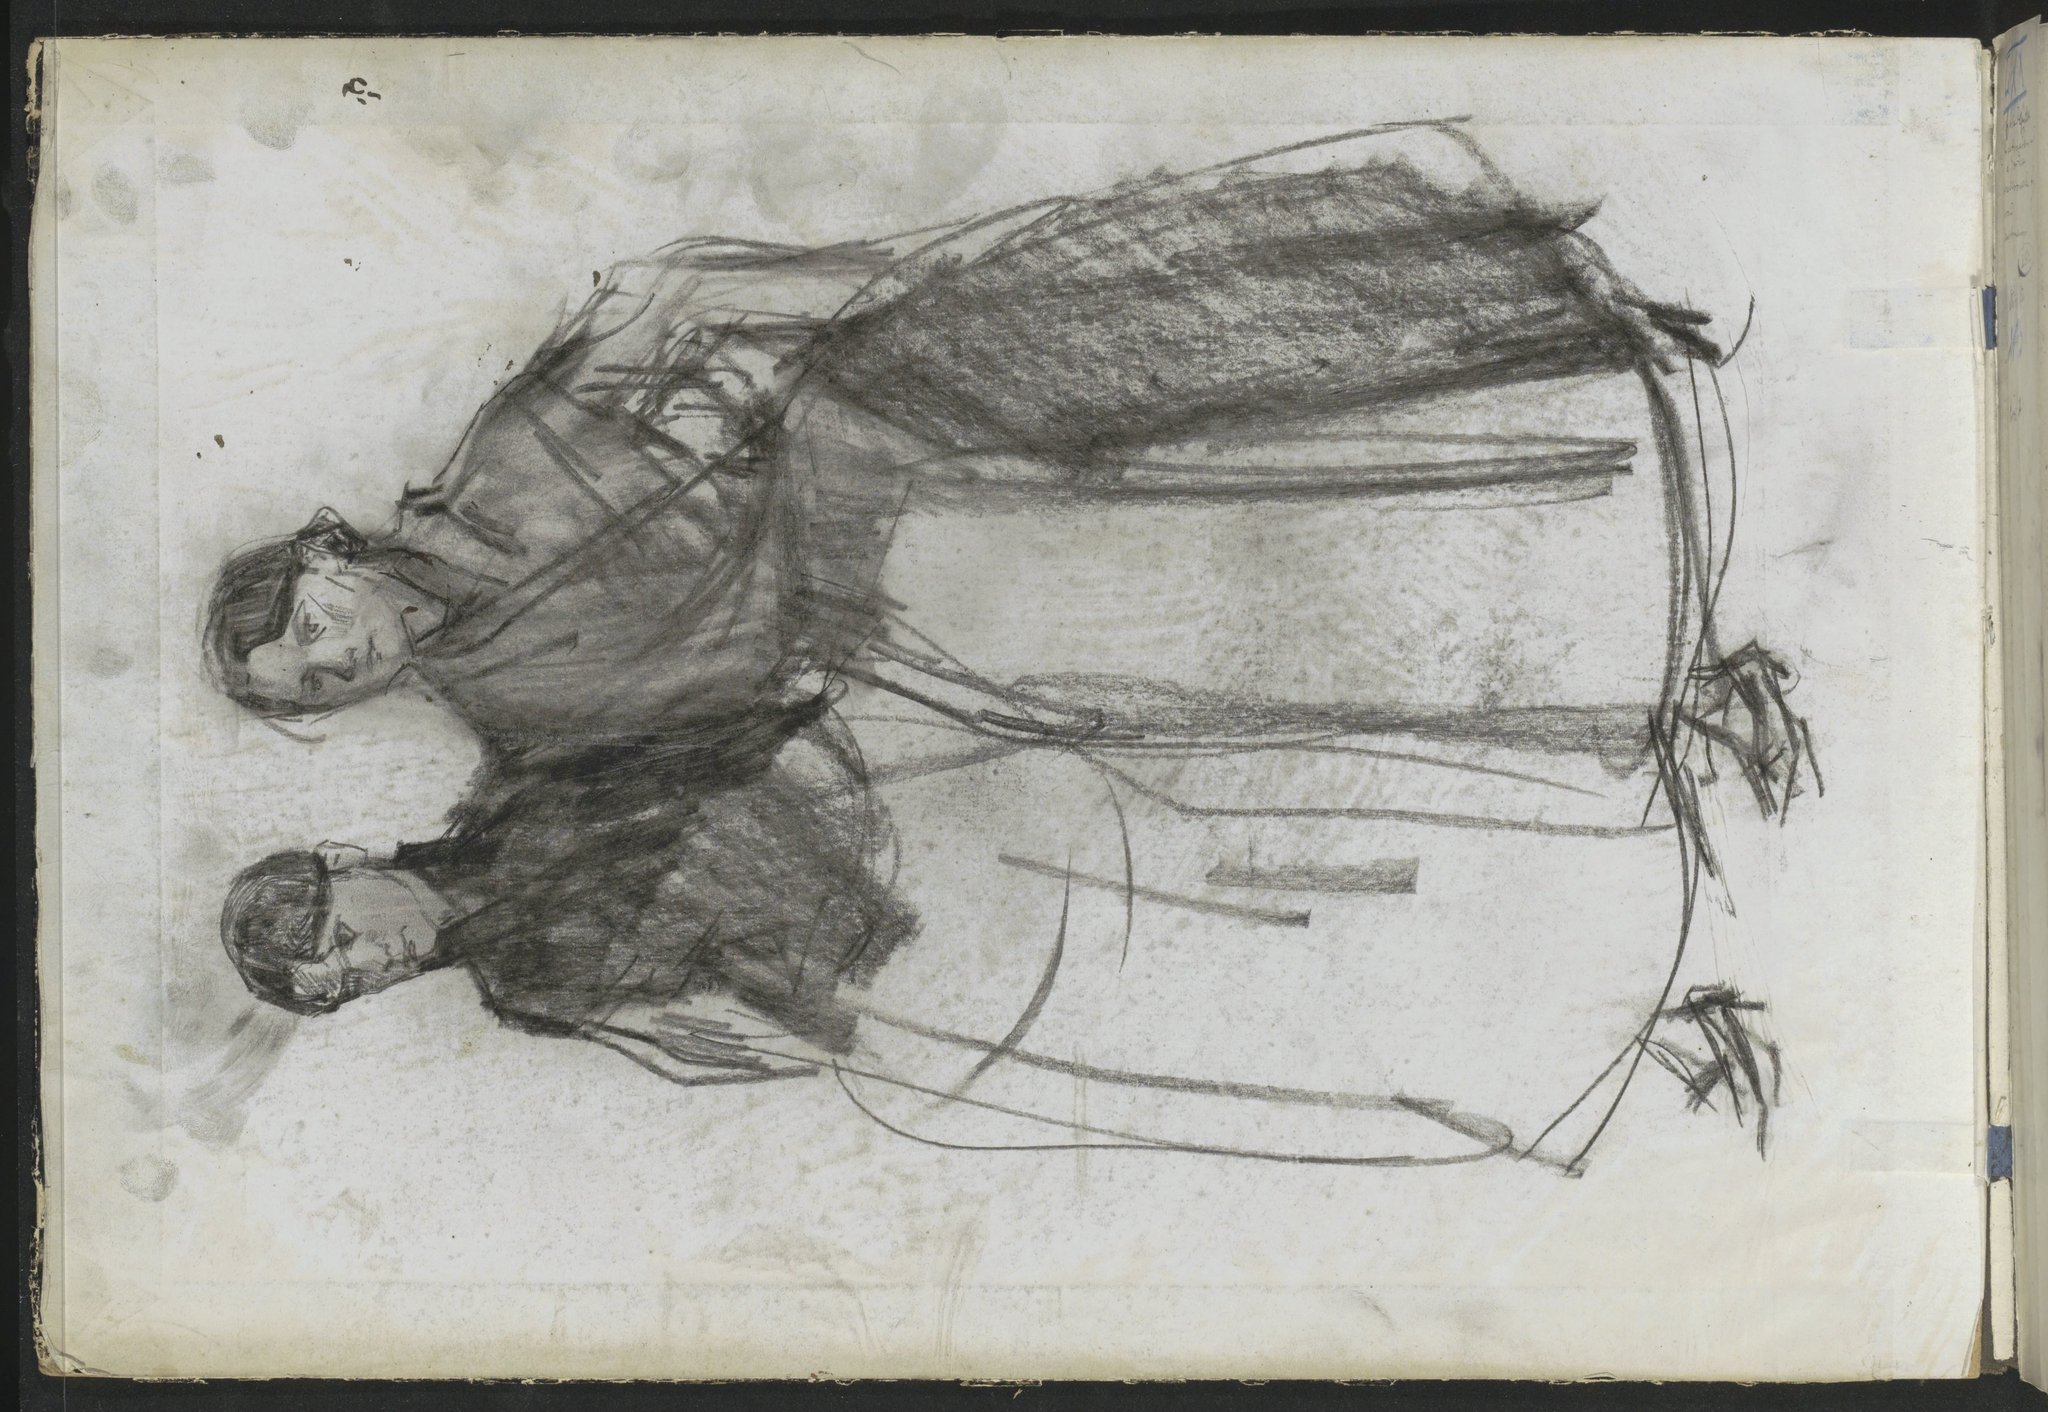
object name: endleaf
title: Twee vrouwen, mogelijk lopend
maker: isaac israels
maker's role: draughtsman, painter, print maker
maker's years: 1865-1934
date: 1886-1934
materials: chalk, charcoal, paper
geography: amsterdam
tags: adult woman (+ standing), walking - aa - female human figure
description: Schutblad A, voorste schutblad, uit schetsboek LXX met 17 bladen.